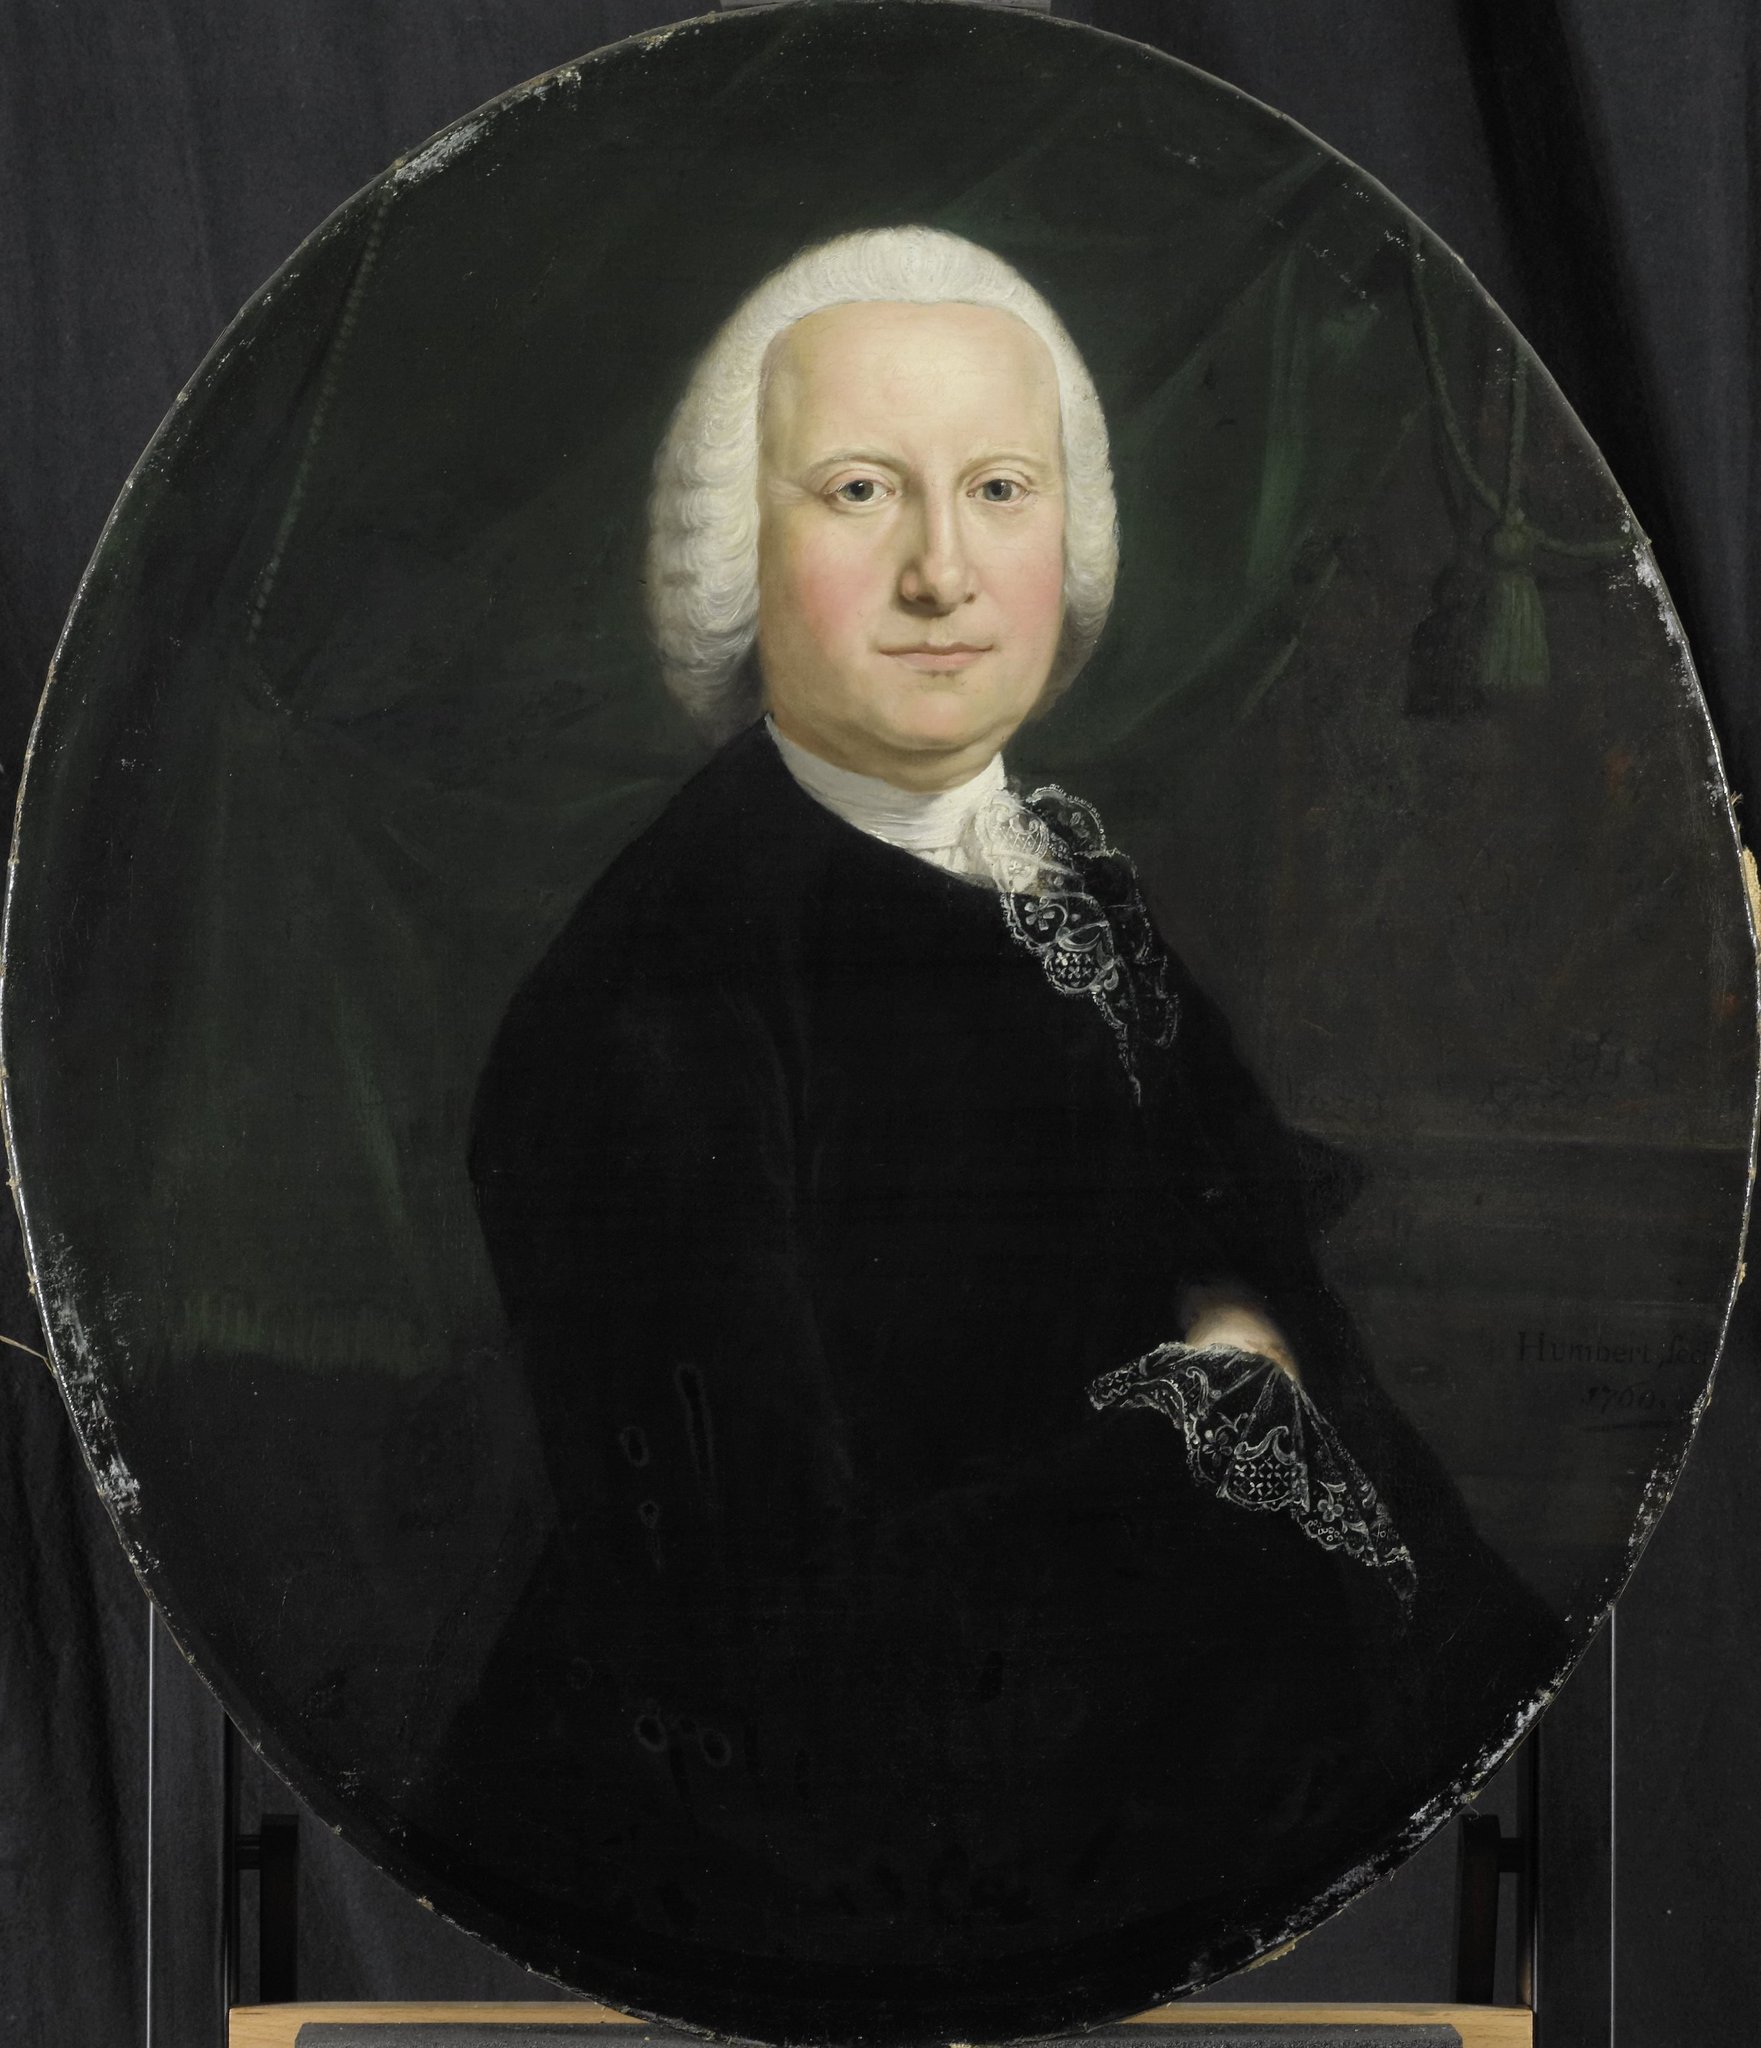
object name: painting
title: Portrait of Adriaan du Bois, Director of the Rotterdam Chamber of the Dutch East India Company, elected 1742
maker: jean humbert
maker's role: draughtsman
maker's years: 1734-1794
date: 1760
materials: canvas, oil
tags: rotterdam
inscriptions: signature and date: ‘Humbert fecit 1760.’, inscription: ‘17 Mr. Adr. Du Bois. 42’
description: Portret van Adriaan du Bois (1713-74), gekozen in 1742. Buste in ovaal naar rechts, het gelaat aanziend. Onderdeel van een reeks portretten van de bewindhebbers van de Rotterdamse Kamer van de Verenigde Oost-Indische Compagnie, vervaardigd voor het Nieuw Oost-Indisch Huis uit 1698 aan de Boompjes te Rotterdam.